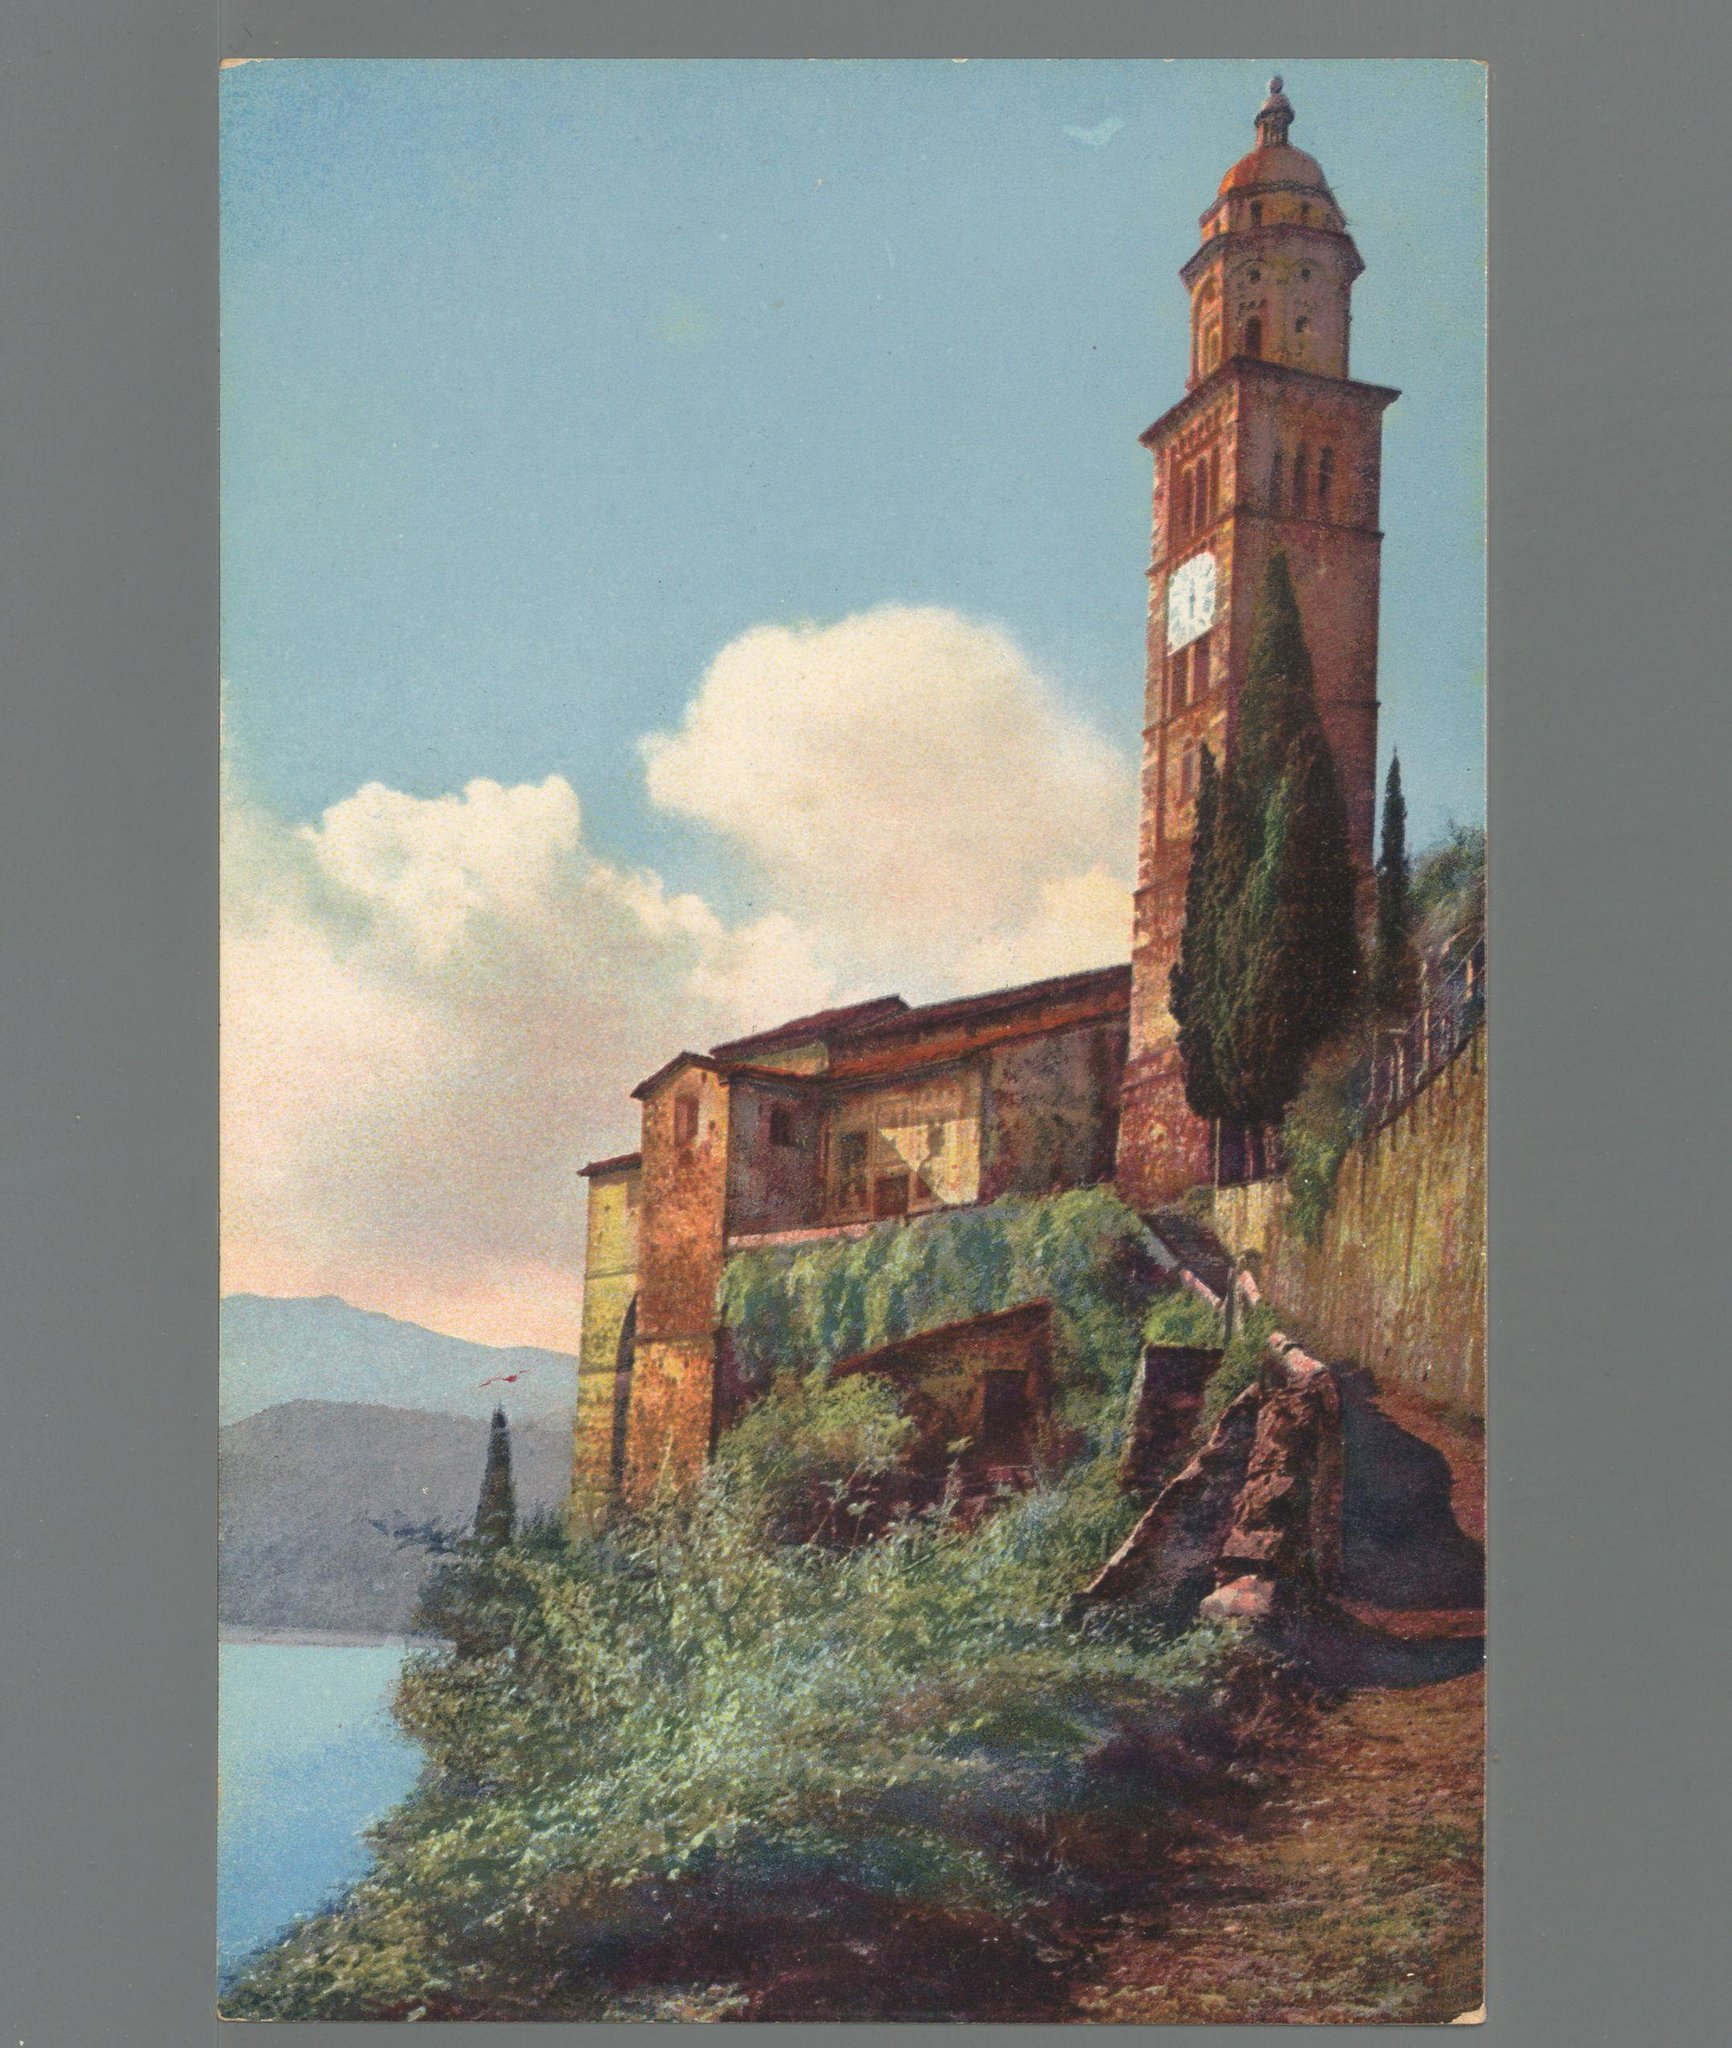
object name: photomechanical print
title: Lago di Lugano. Morcote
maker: Anonymous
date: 1905-1920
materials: cardboard, photographic process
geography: morcote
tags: church (exterior), lake